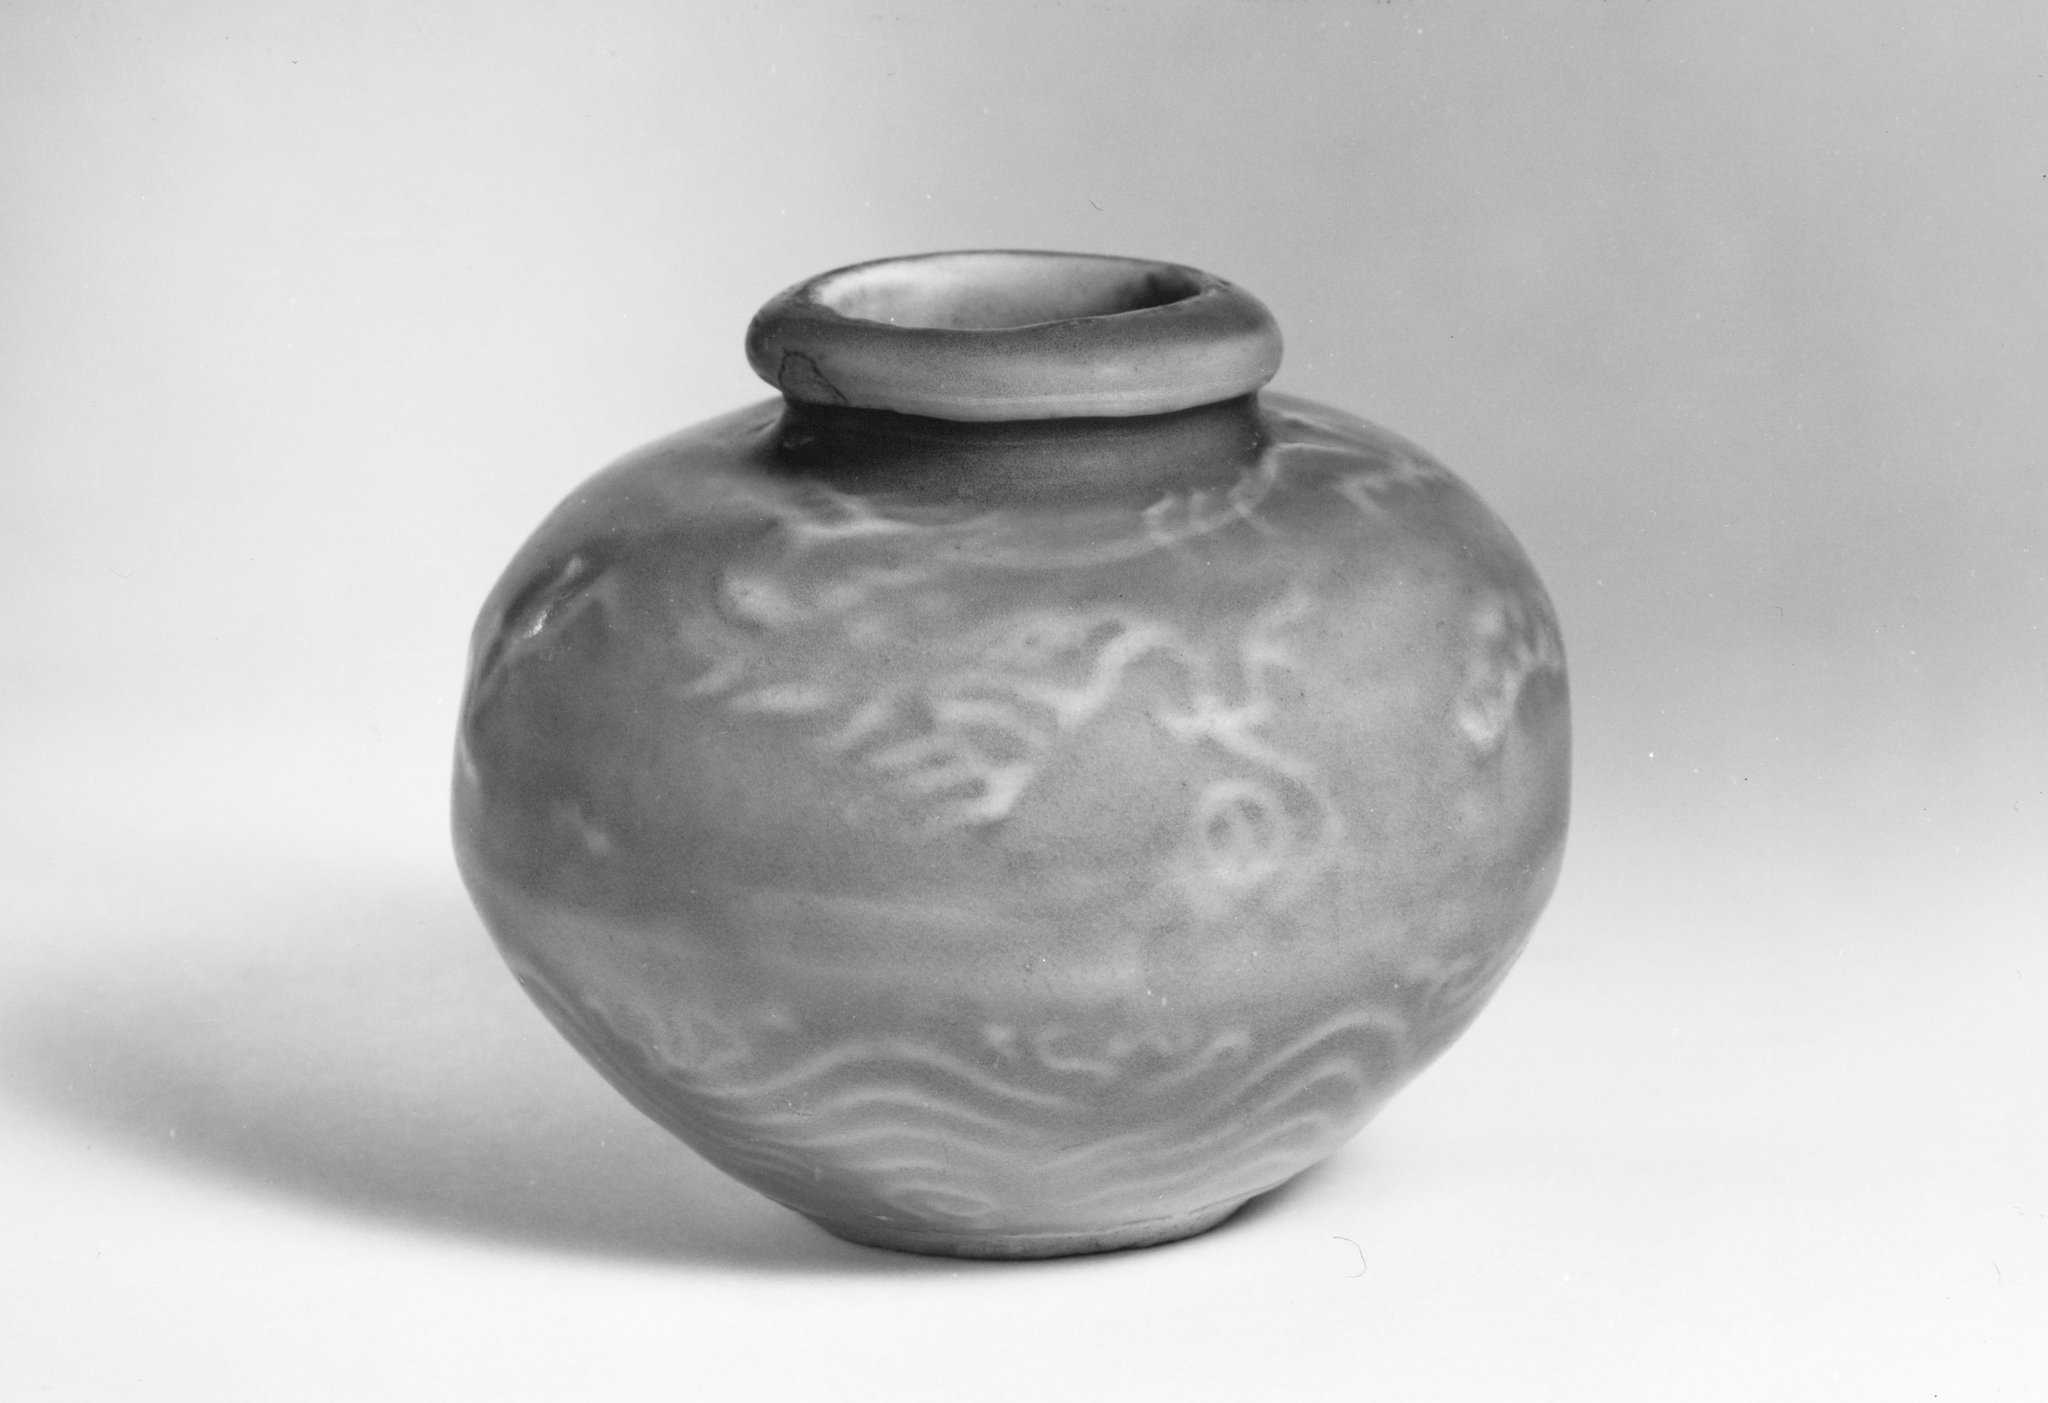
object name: jar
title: Small Jar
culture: chinese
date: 1301-1400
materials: stoneware